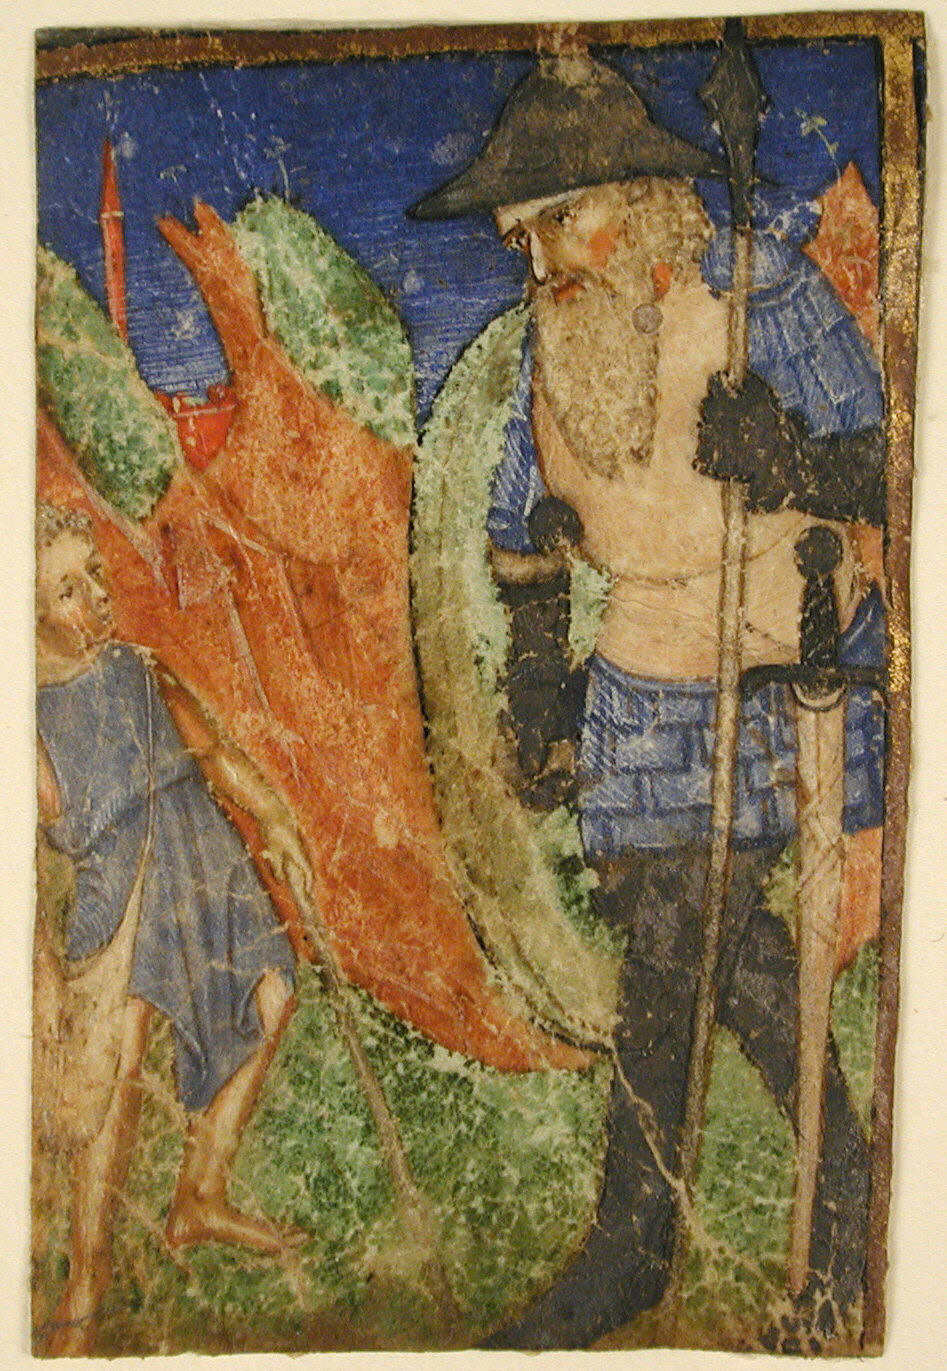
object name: manuscript cutting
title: David and Goliath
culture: french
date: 1400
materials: ink, metal leaf, parchment, paint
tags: david